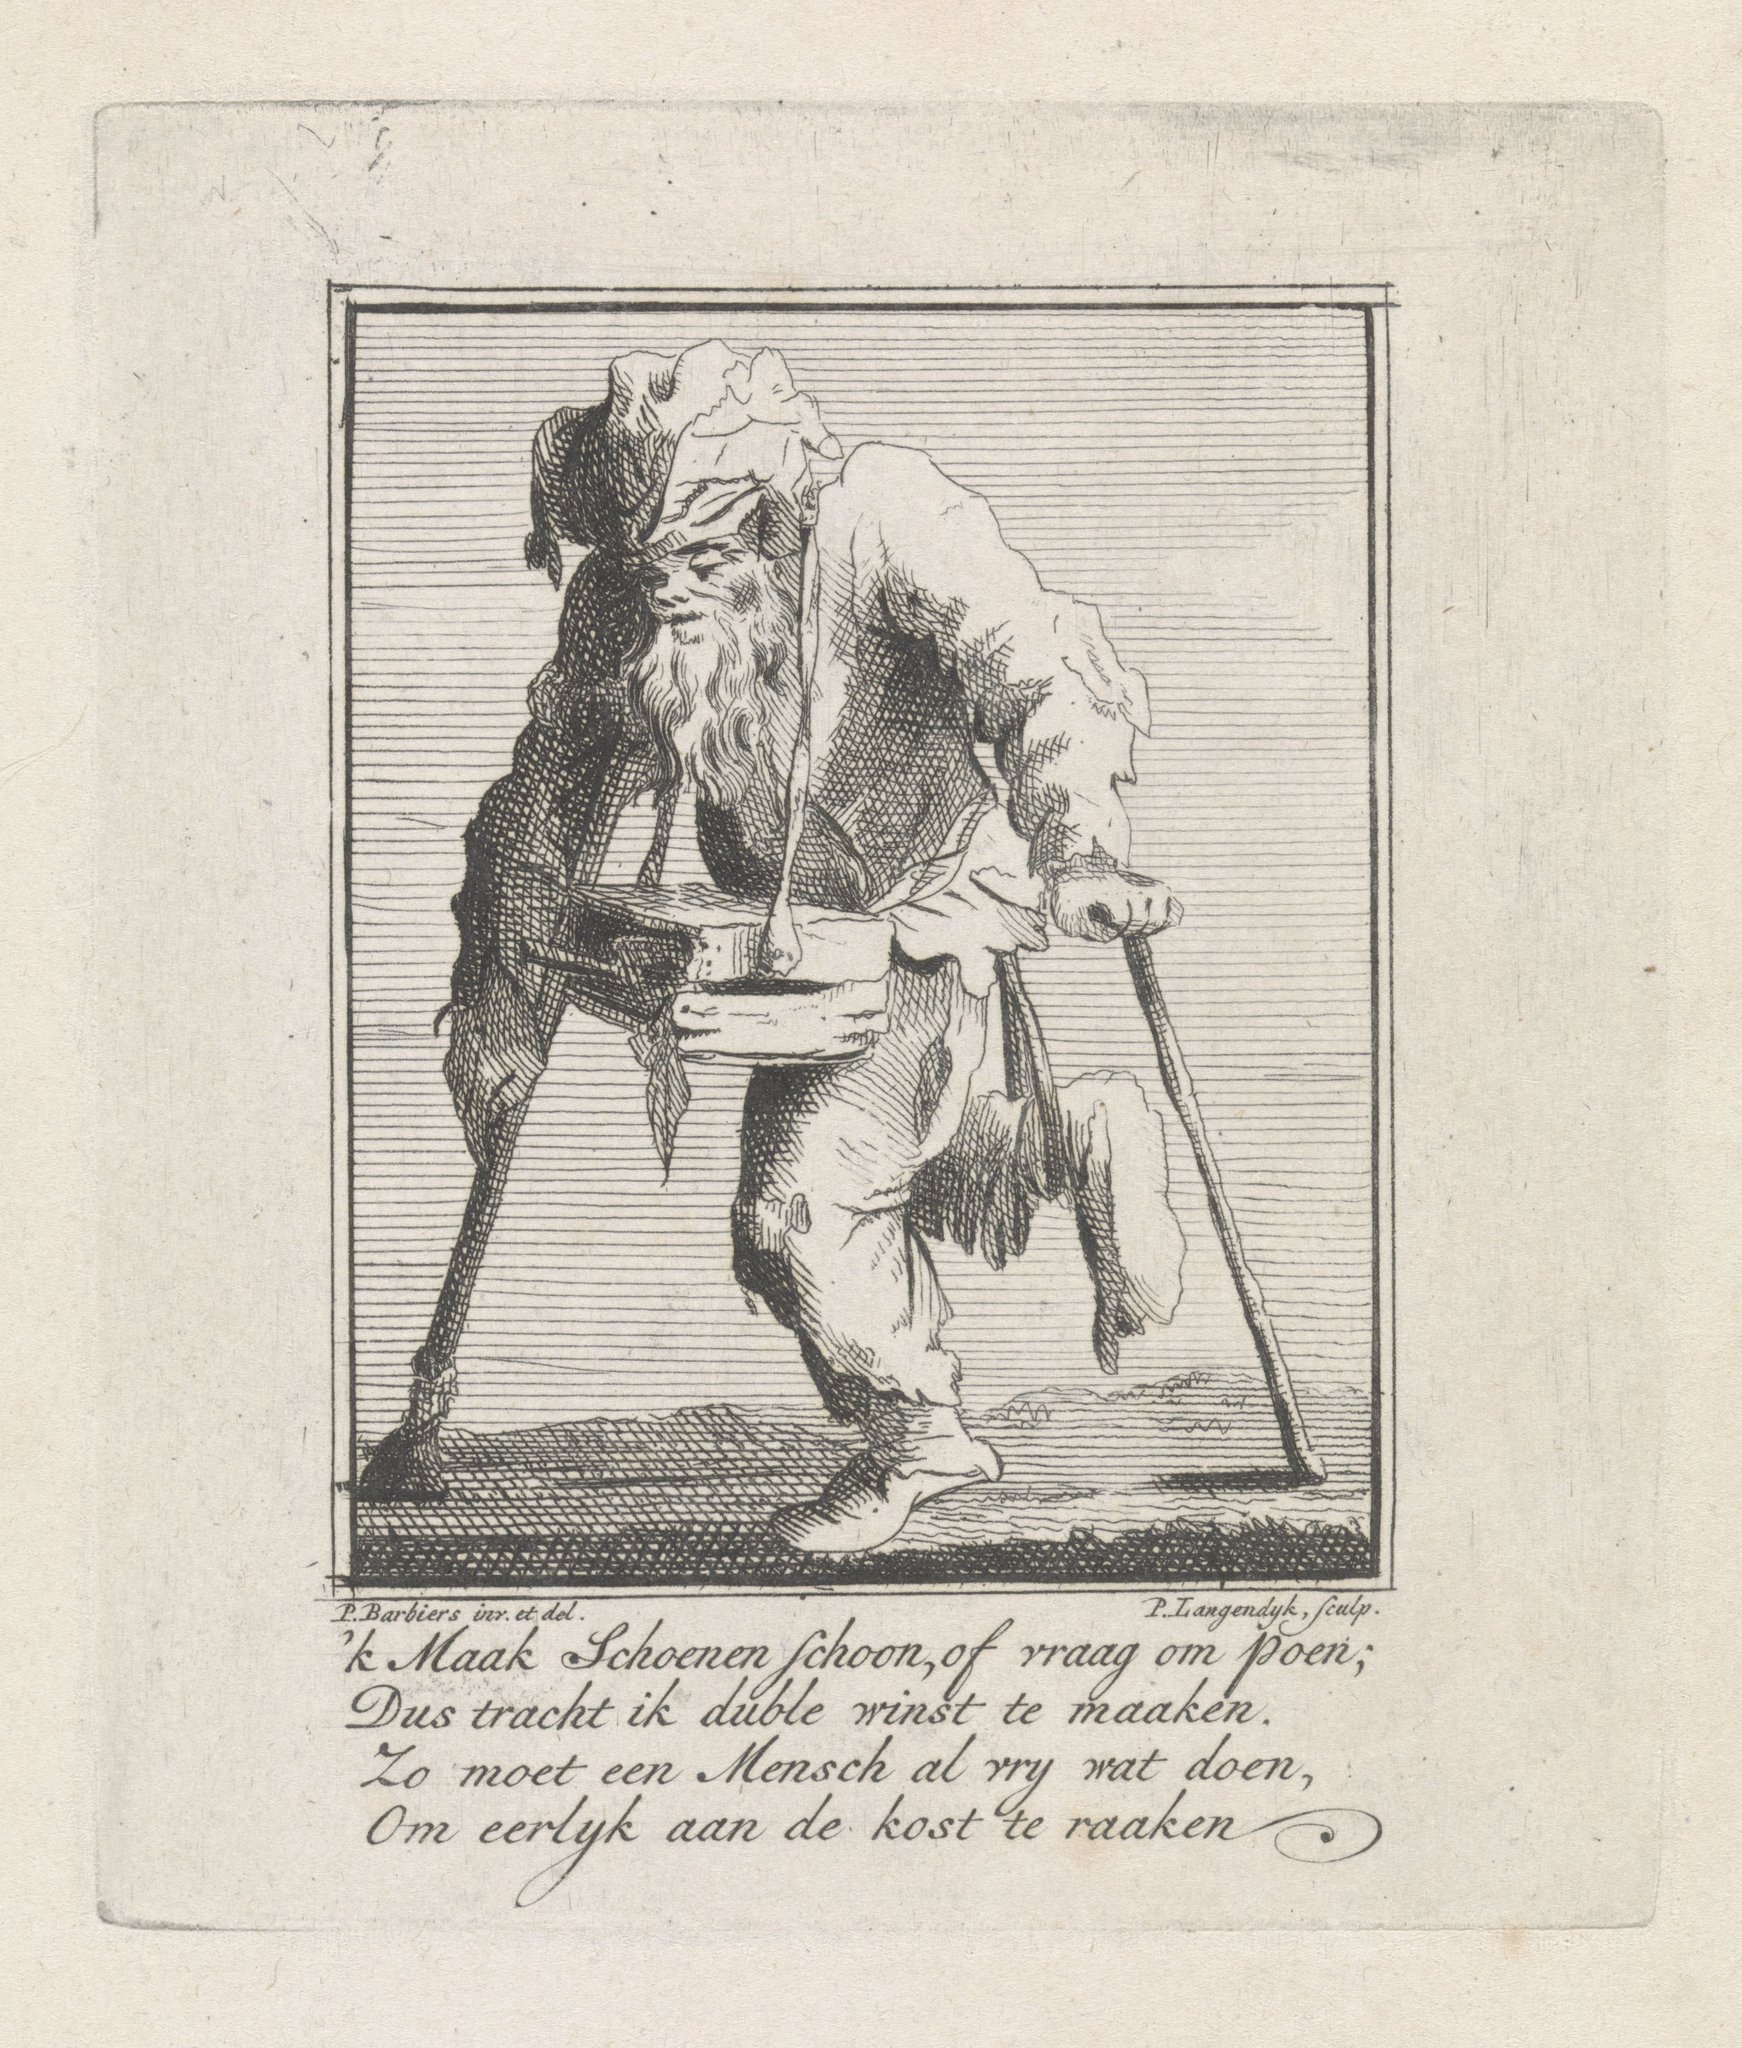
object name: print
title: Man lopend met twee krukken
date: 1770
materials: paper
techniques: engraving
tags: accessories ~ shoes, e.g. insole, shoehorn, shoe-polish, crutches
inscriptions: collector's mark: Lugt 240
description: Een man beweegt zich met twee krukken voort en draagt een schoenpoetskistje om zijn nek. In de marge een vierregelig vers in het Nederlands. Onderdeel van een serie prenten van Amsterdamse straatfiguren rond 1770.